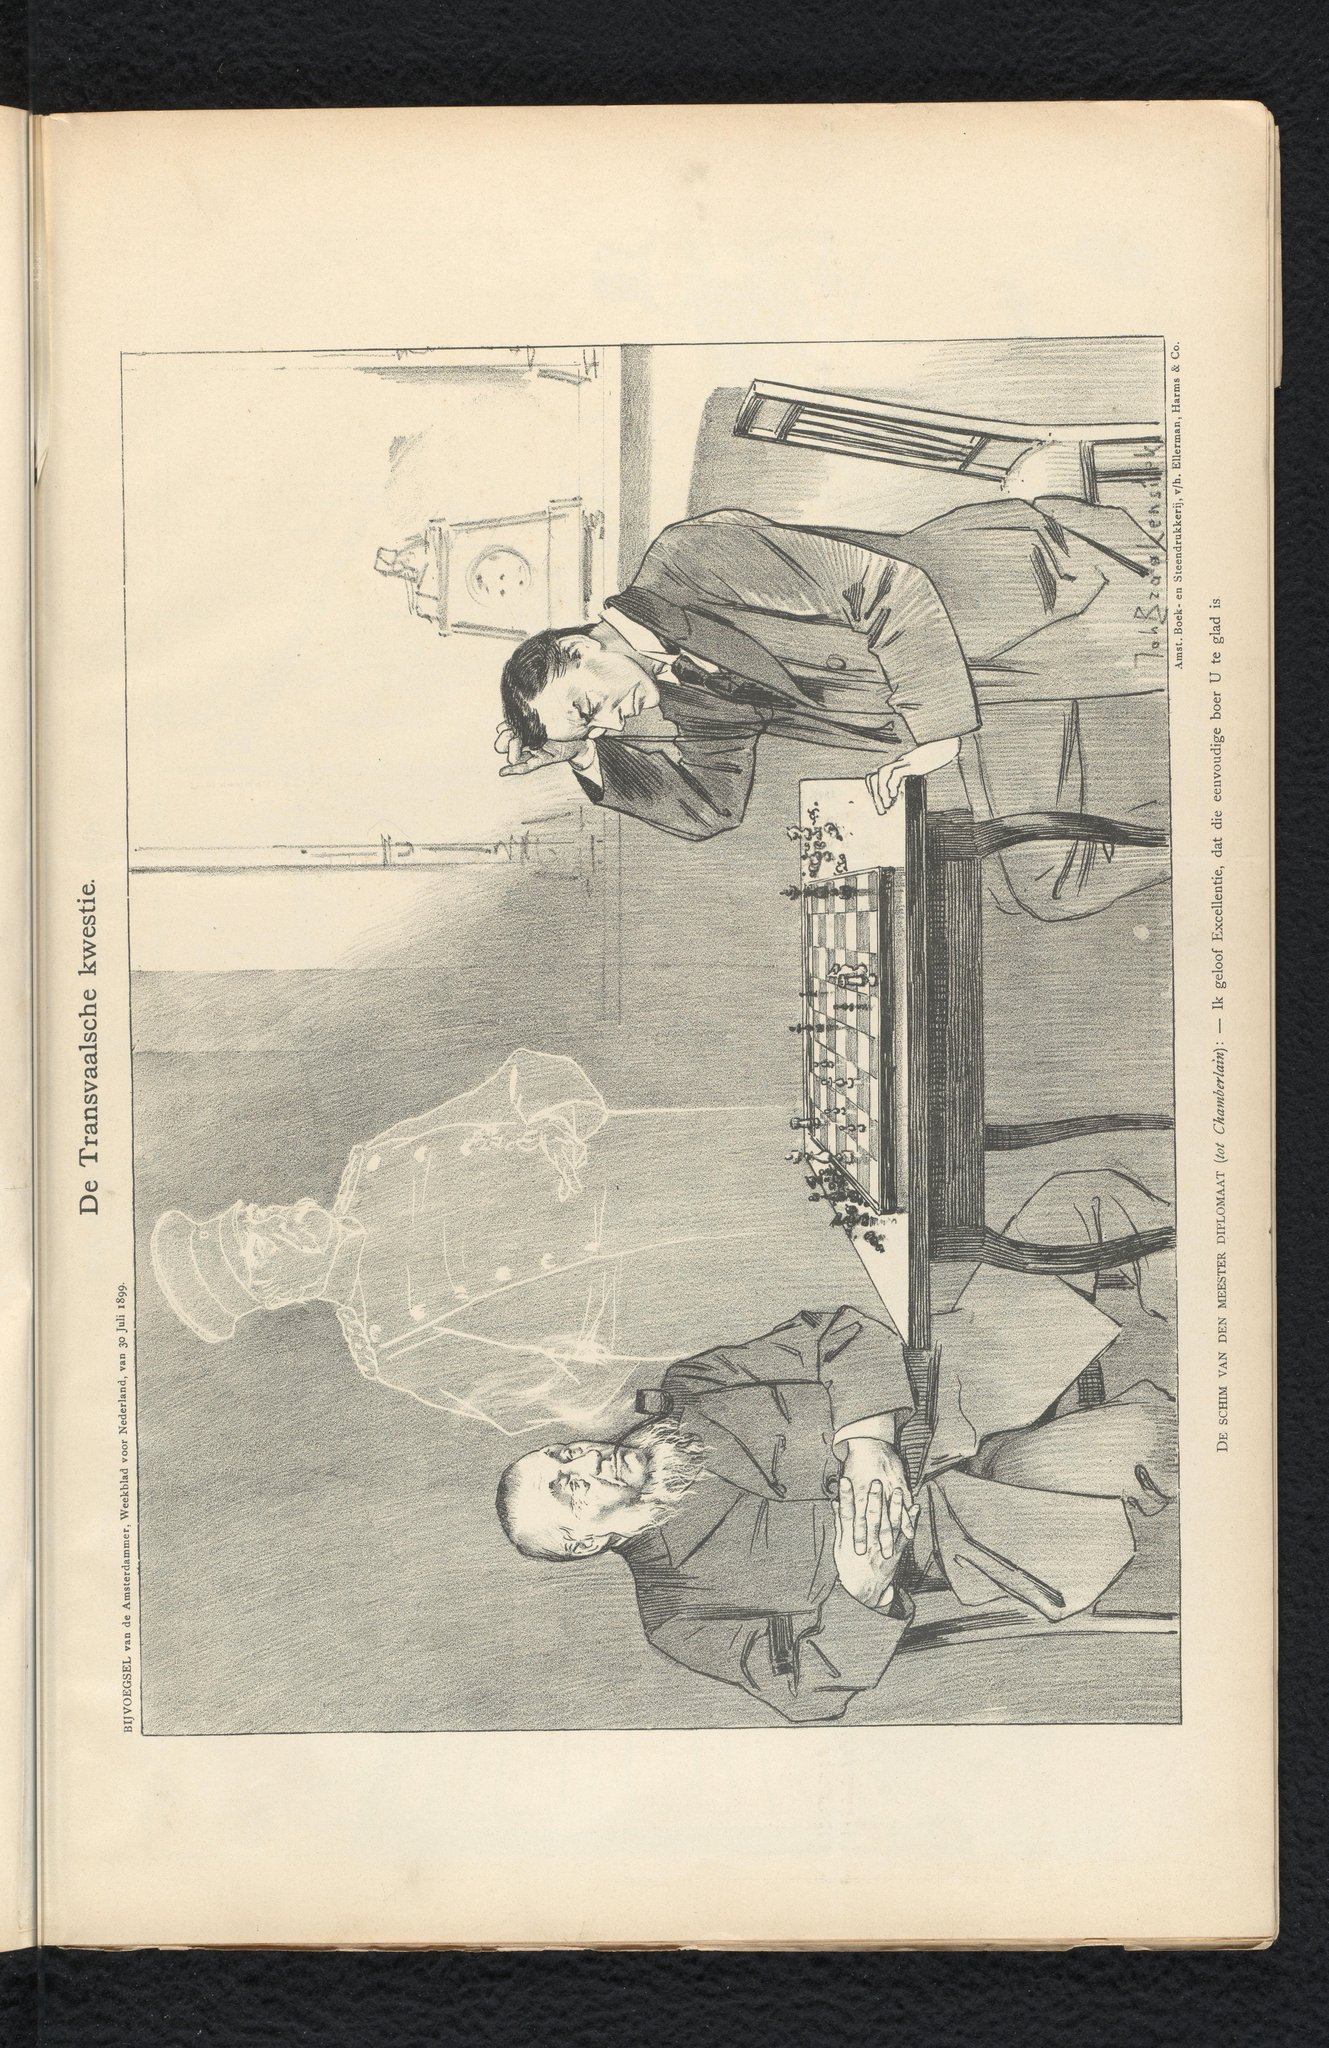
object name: cartoon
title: De Transvaalsche kwestie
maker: johan braakensiek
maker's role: draughtsman, print maker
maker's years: 1858-1940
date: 1899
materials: paper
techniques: lithograph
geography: netherlands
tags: chess, political caricatures and satires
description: Paul Kruger en Joseph Chamberlain spelen een schaakwedstrijd tegen elkaar. Een schim ('de meester diplomaat', mogelijk Bismarck) laat Chamberlain weten dat de 'eenvoudige boer', Kruger, hem te slim af is. In aanloop naar de Tweede Boerenoorlog.